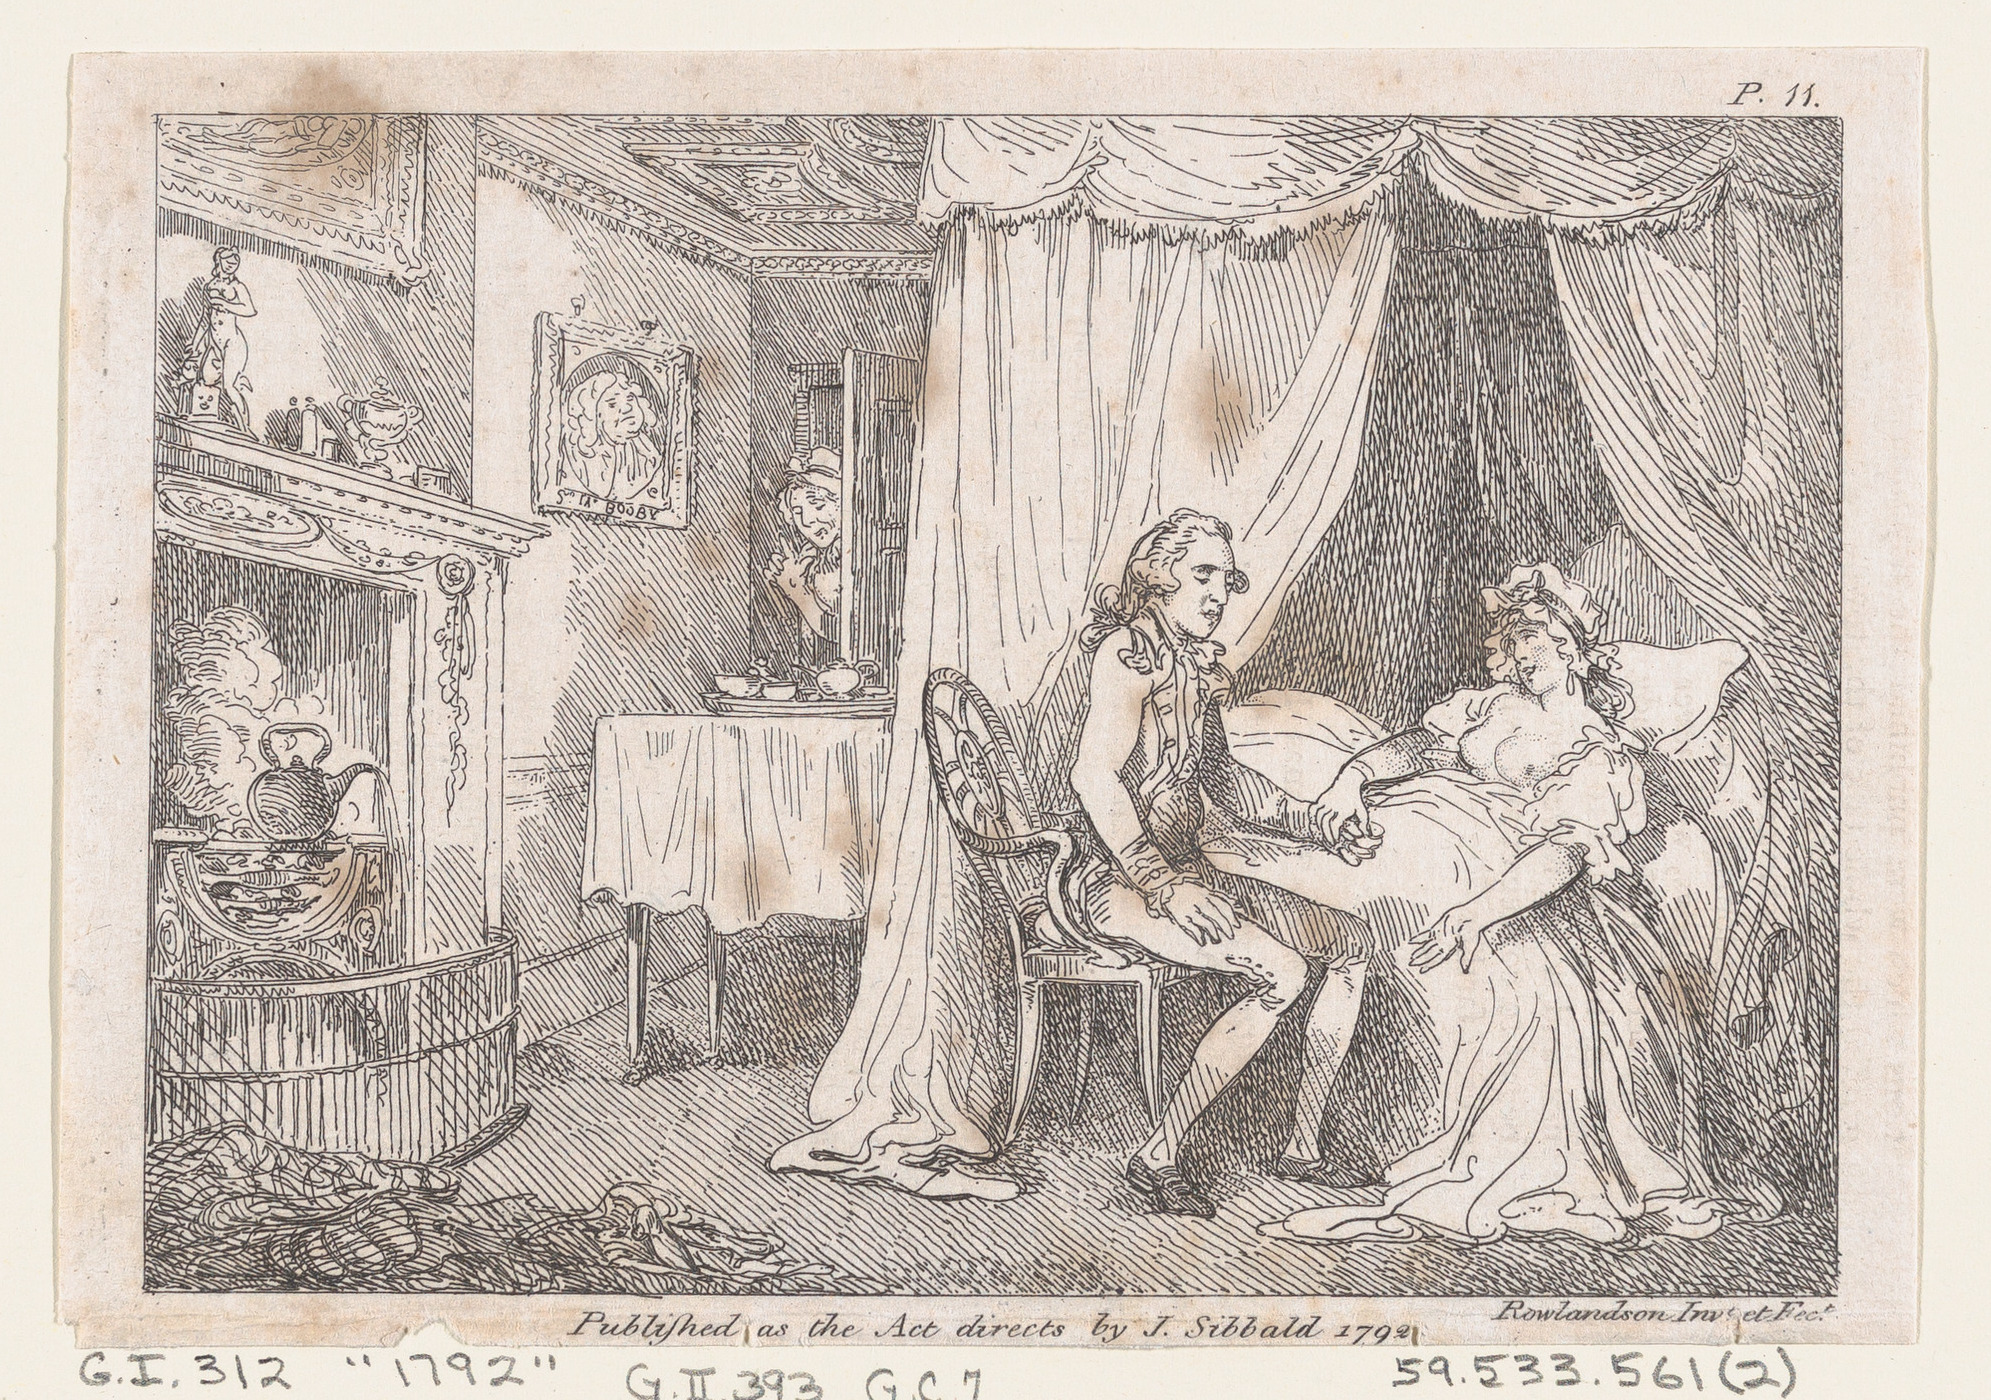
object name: print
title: Lady Booby attempts to seduce the immaculate Joseph, from "The Adventures of Joseph Andrews, and His Friend Mr. Abraham Adams"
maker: thomas rowlandson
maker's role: artist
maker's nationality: british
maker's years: 1757-1827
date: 1792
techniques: etching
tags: satire,bedrooms,men,women